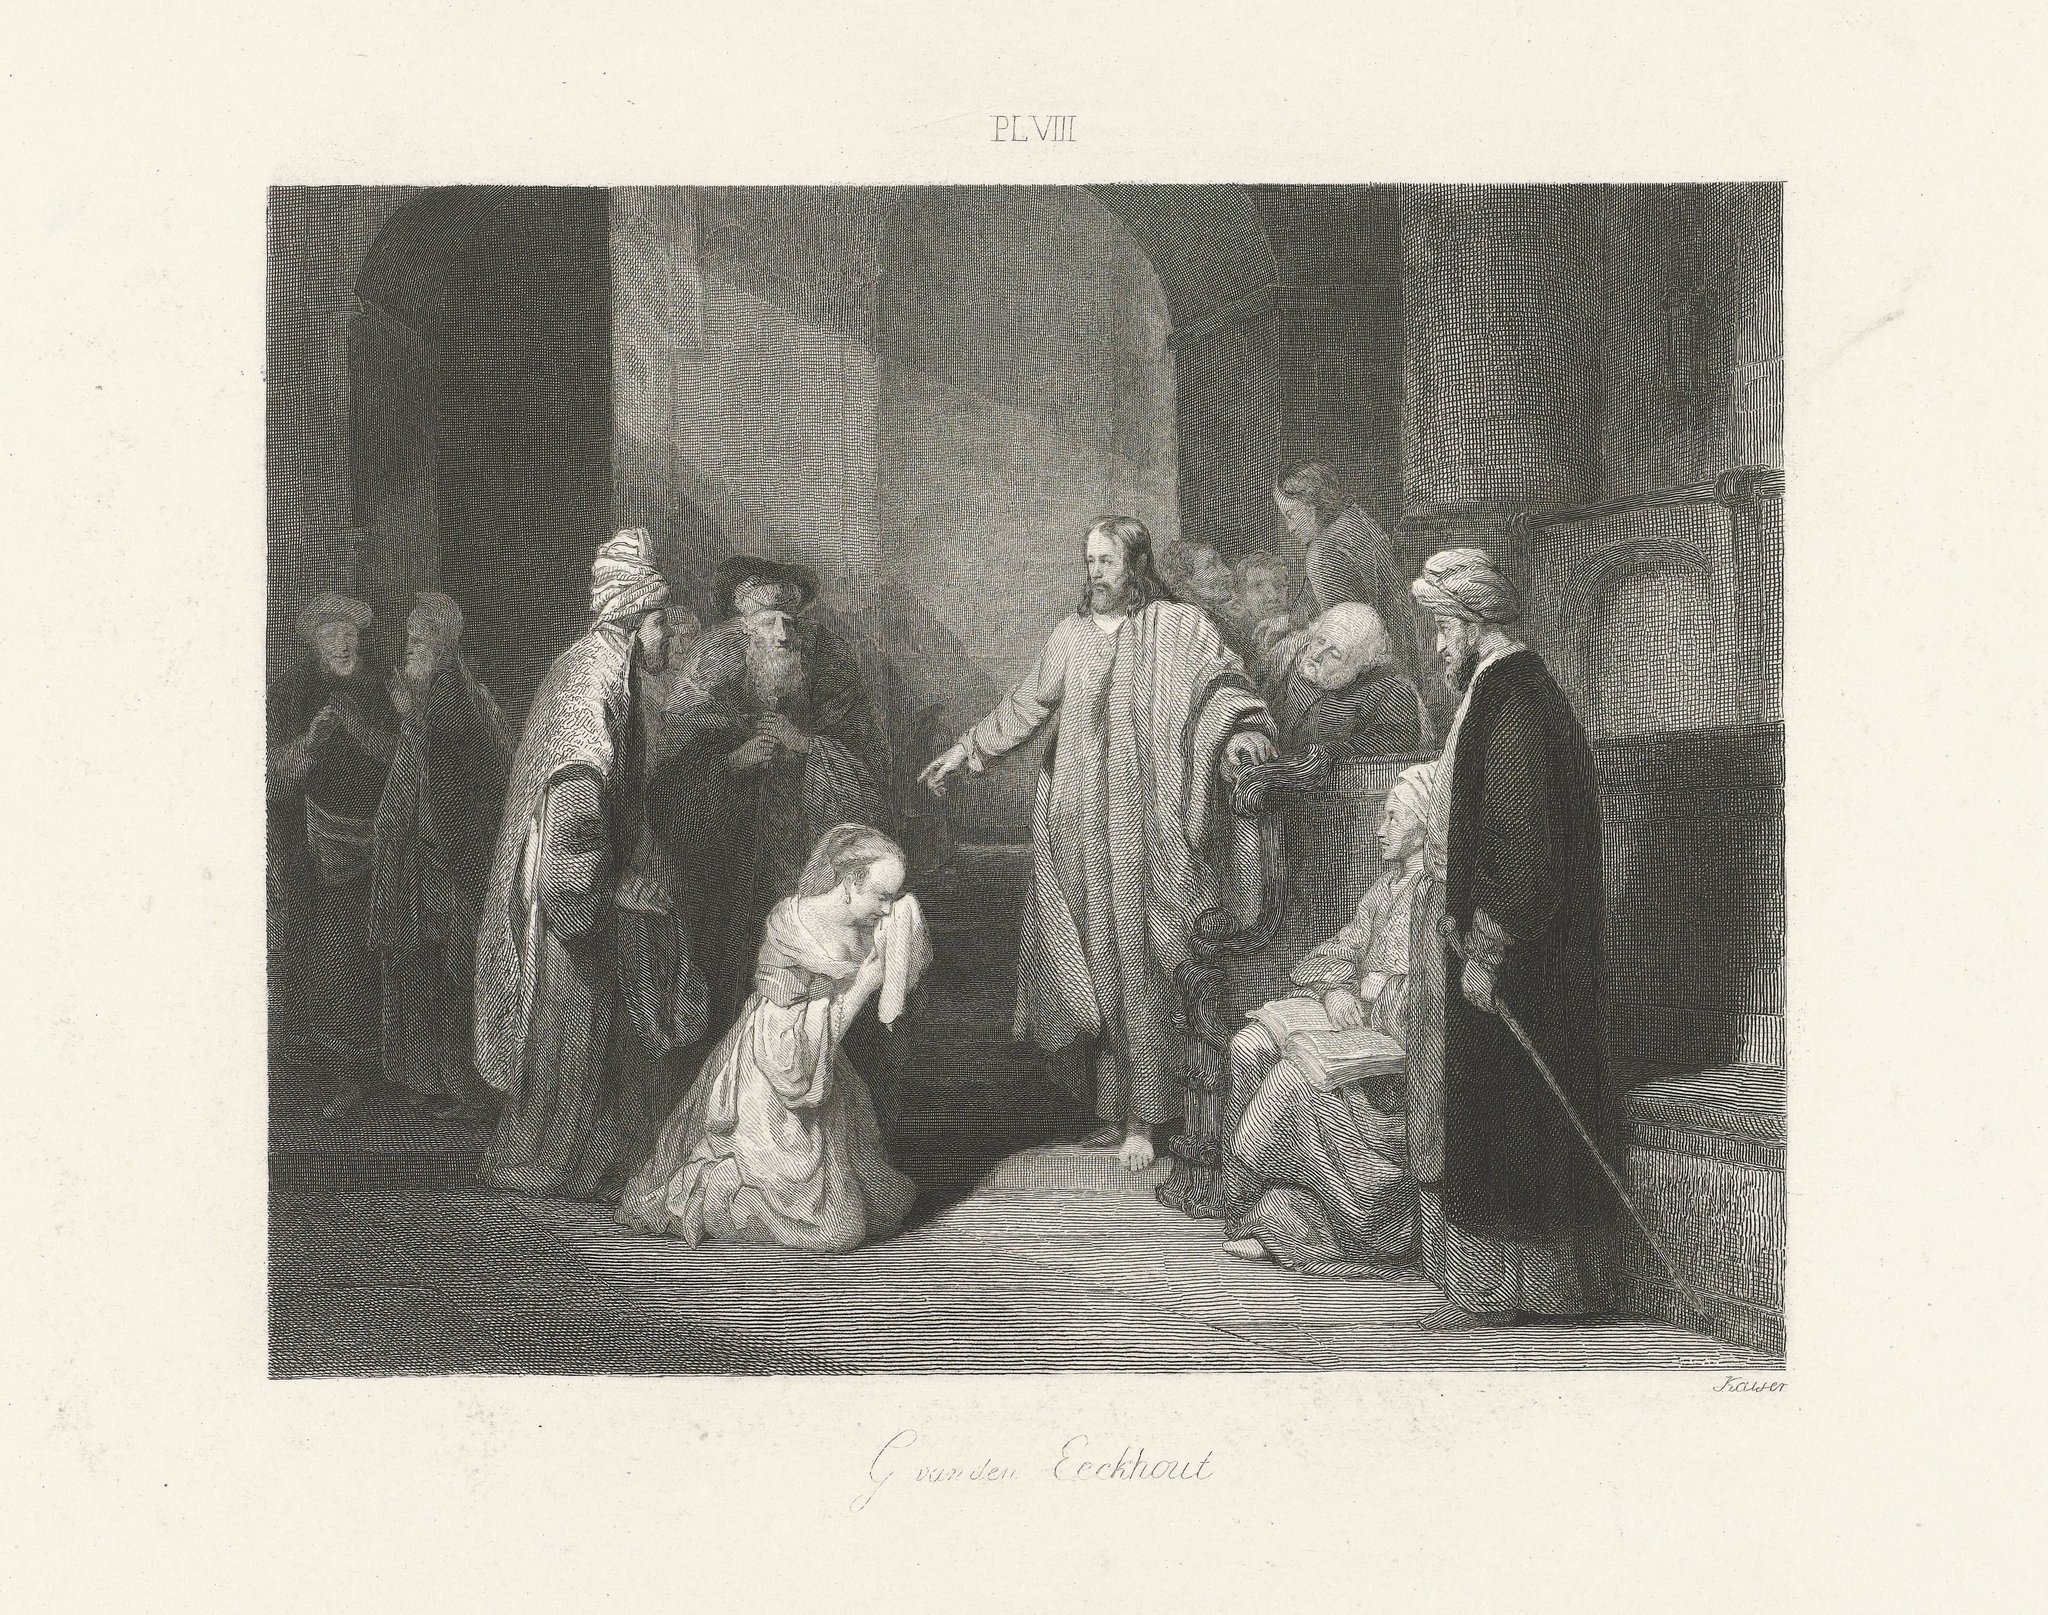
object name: print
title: Hollandse meesters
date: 1823-1900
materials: paper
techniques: etching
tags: pharisees bring a woman accused of adultery before christ (john 8:2-11)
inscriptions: collector's mark: Lugt 2228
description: Links op de voorgrond zit de overspelige vrouw op haar knieën, achter haar twee oude mannen. Rechts staat Christus. De prent maakt deel uit van een serie van 25 prenten naar Hollandse meesters. Boven de afbeelding: PL VIII.